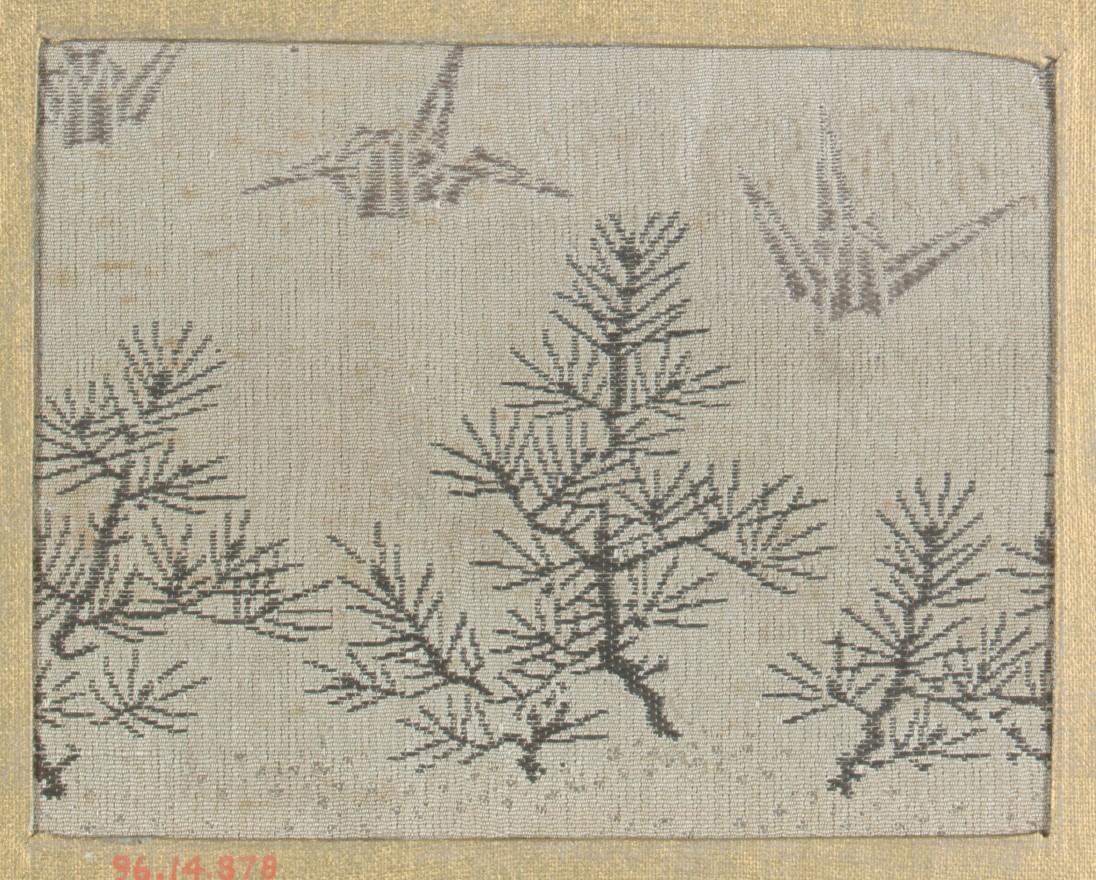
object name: piece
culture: japanese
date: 1701-1900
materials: silk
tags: cranes,trees